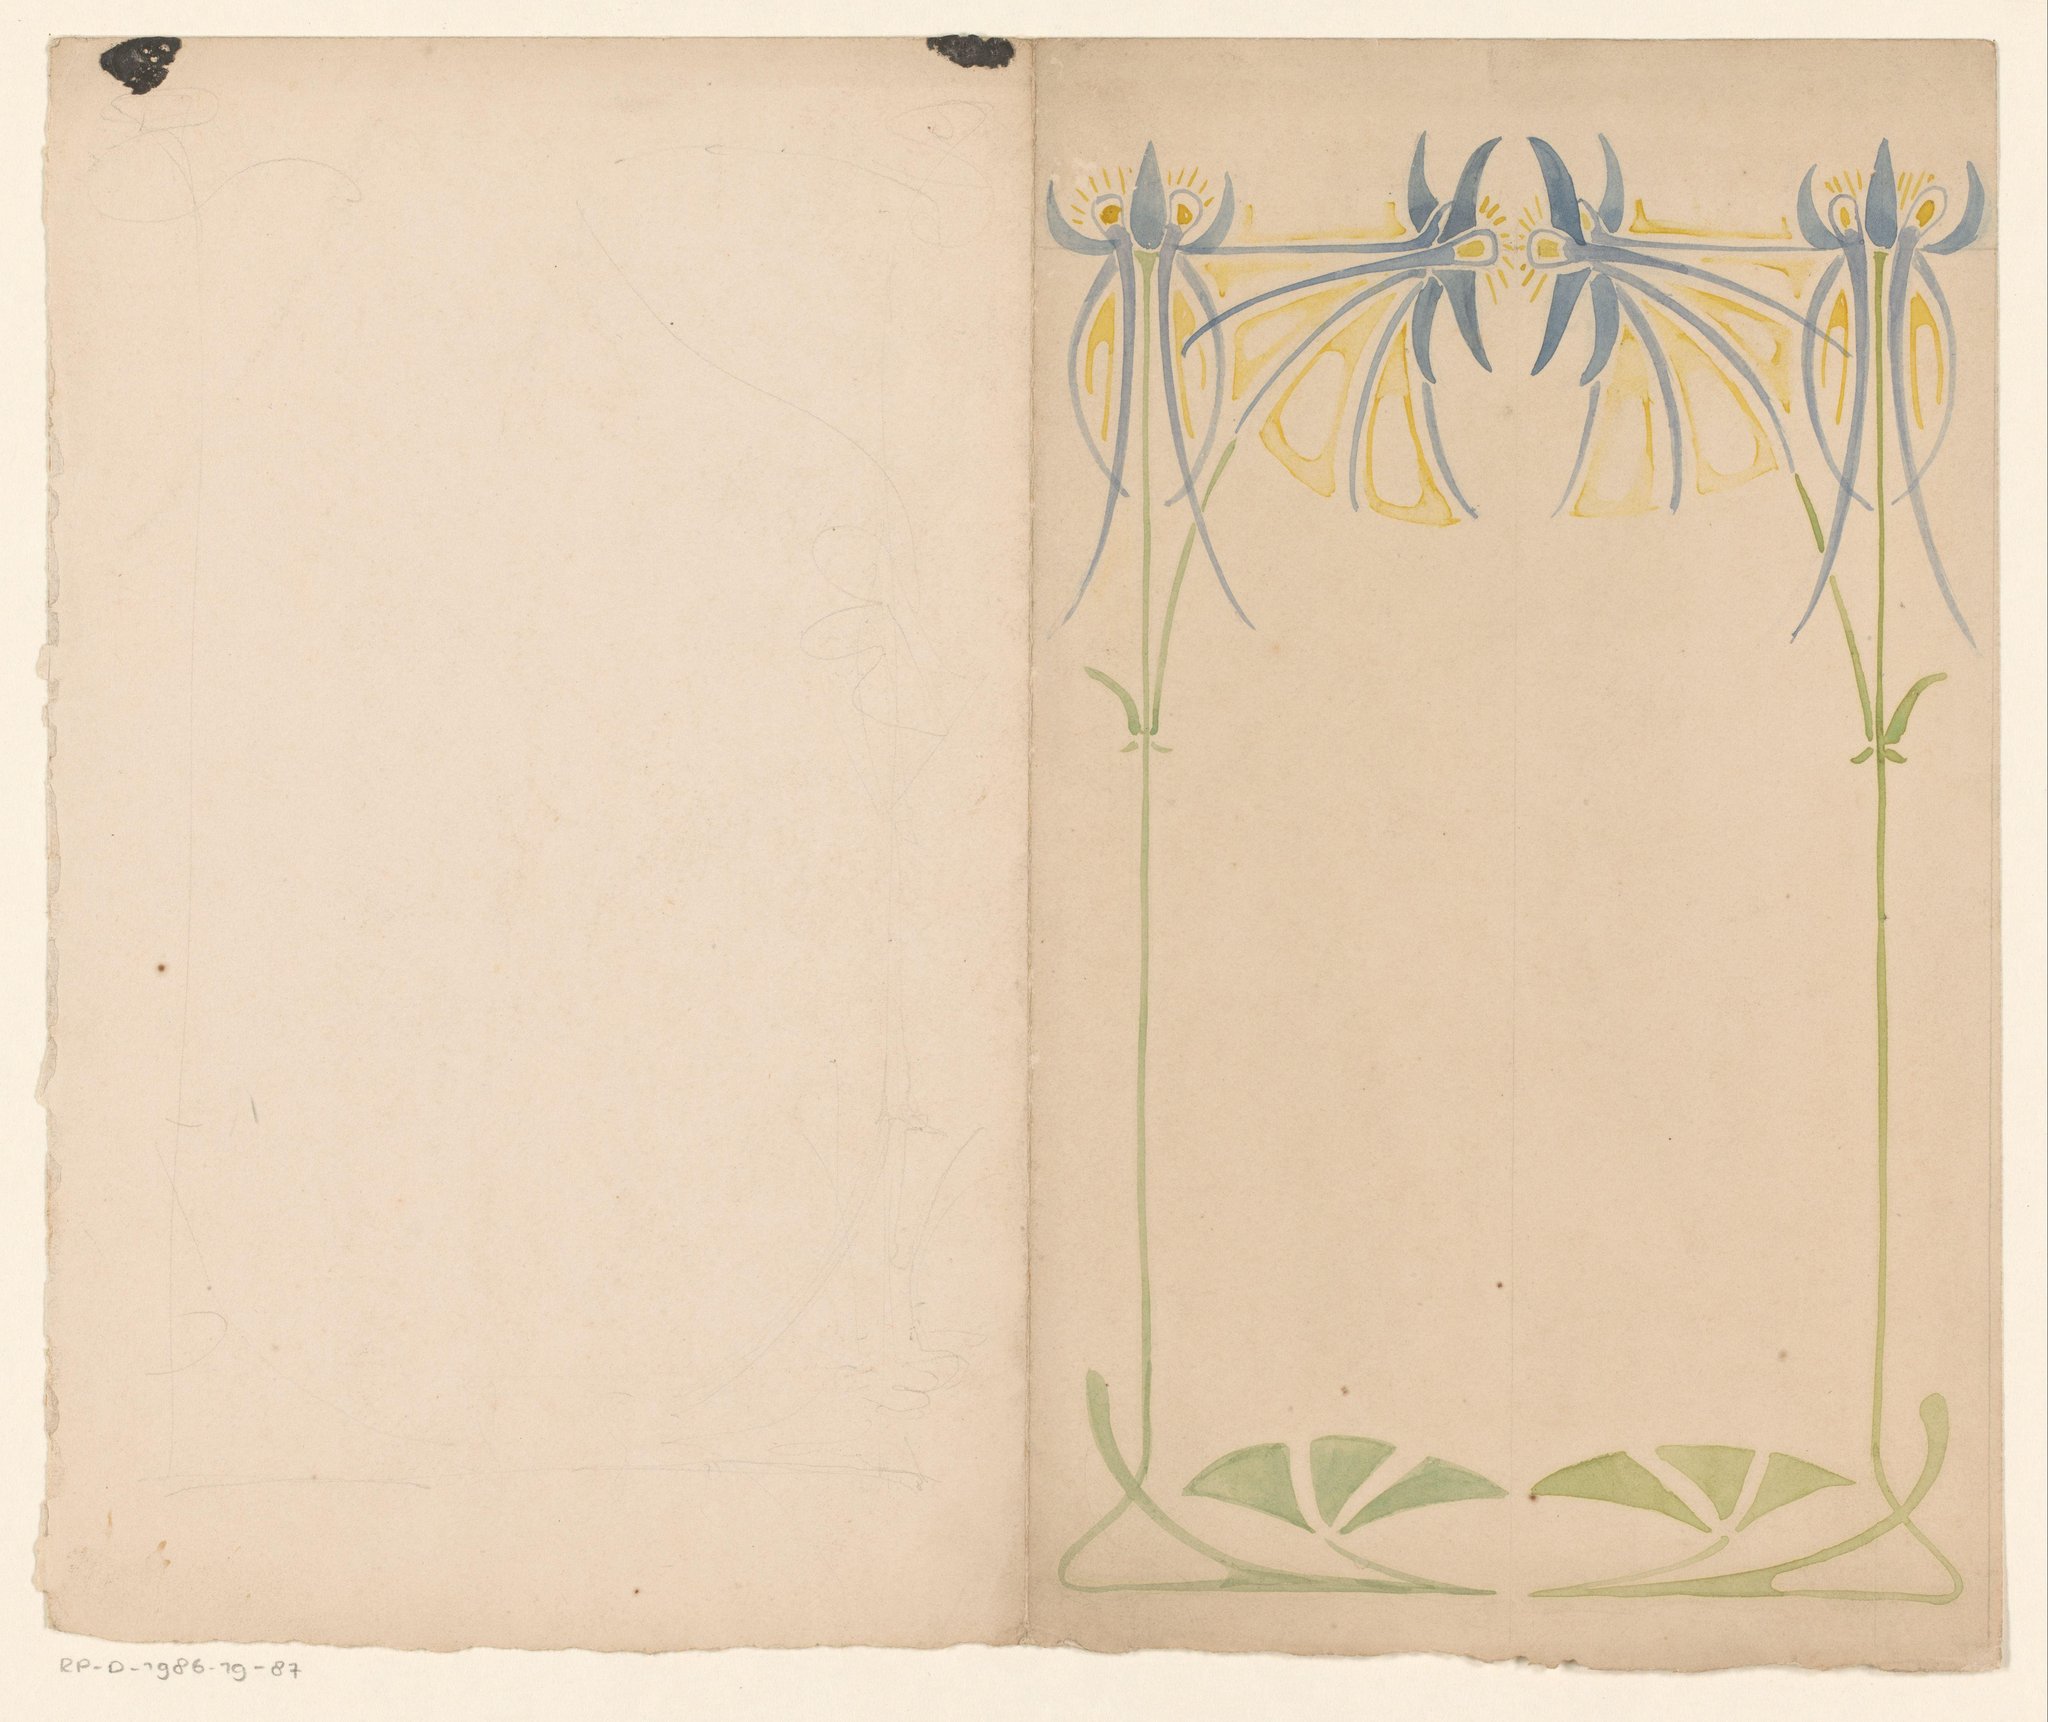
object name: drawing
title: Bandontwerp met een kader met plantmotieven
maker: reinier willem petrus de vries (1874-1953)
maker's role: draughtsman, print maker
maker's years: 1874-1953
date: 1884-1952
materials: paper, pencil, watercolor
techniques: brush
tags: ornament derived from plant forms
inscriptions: collector's mark: ‘R:MVS.’